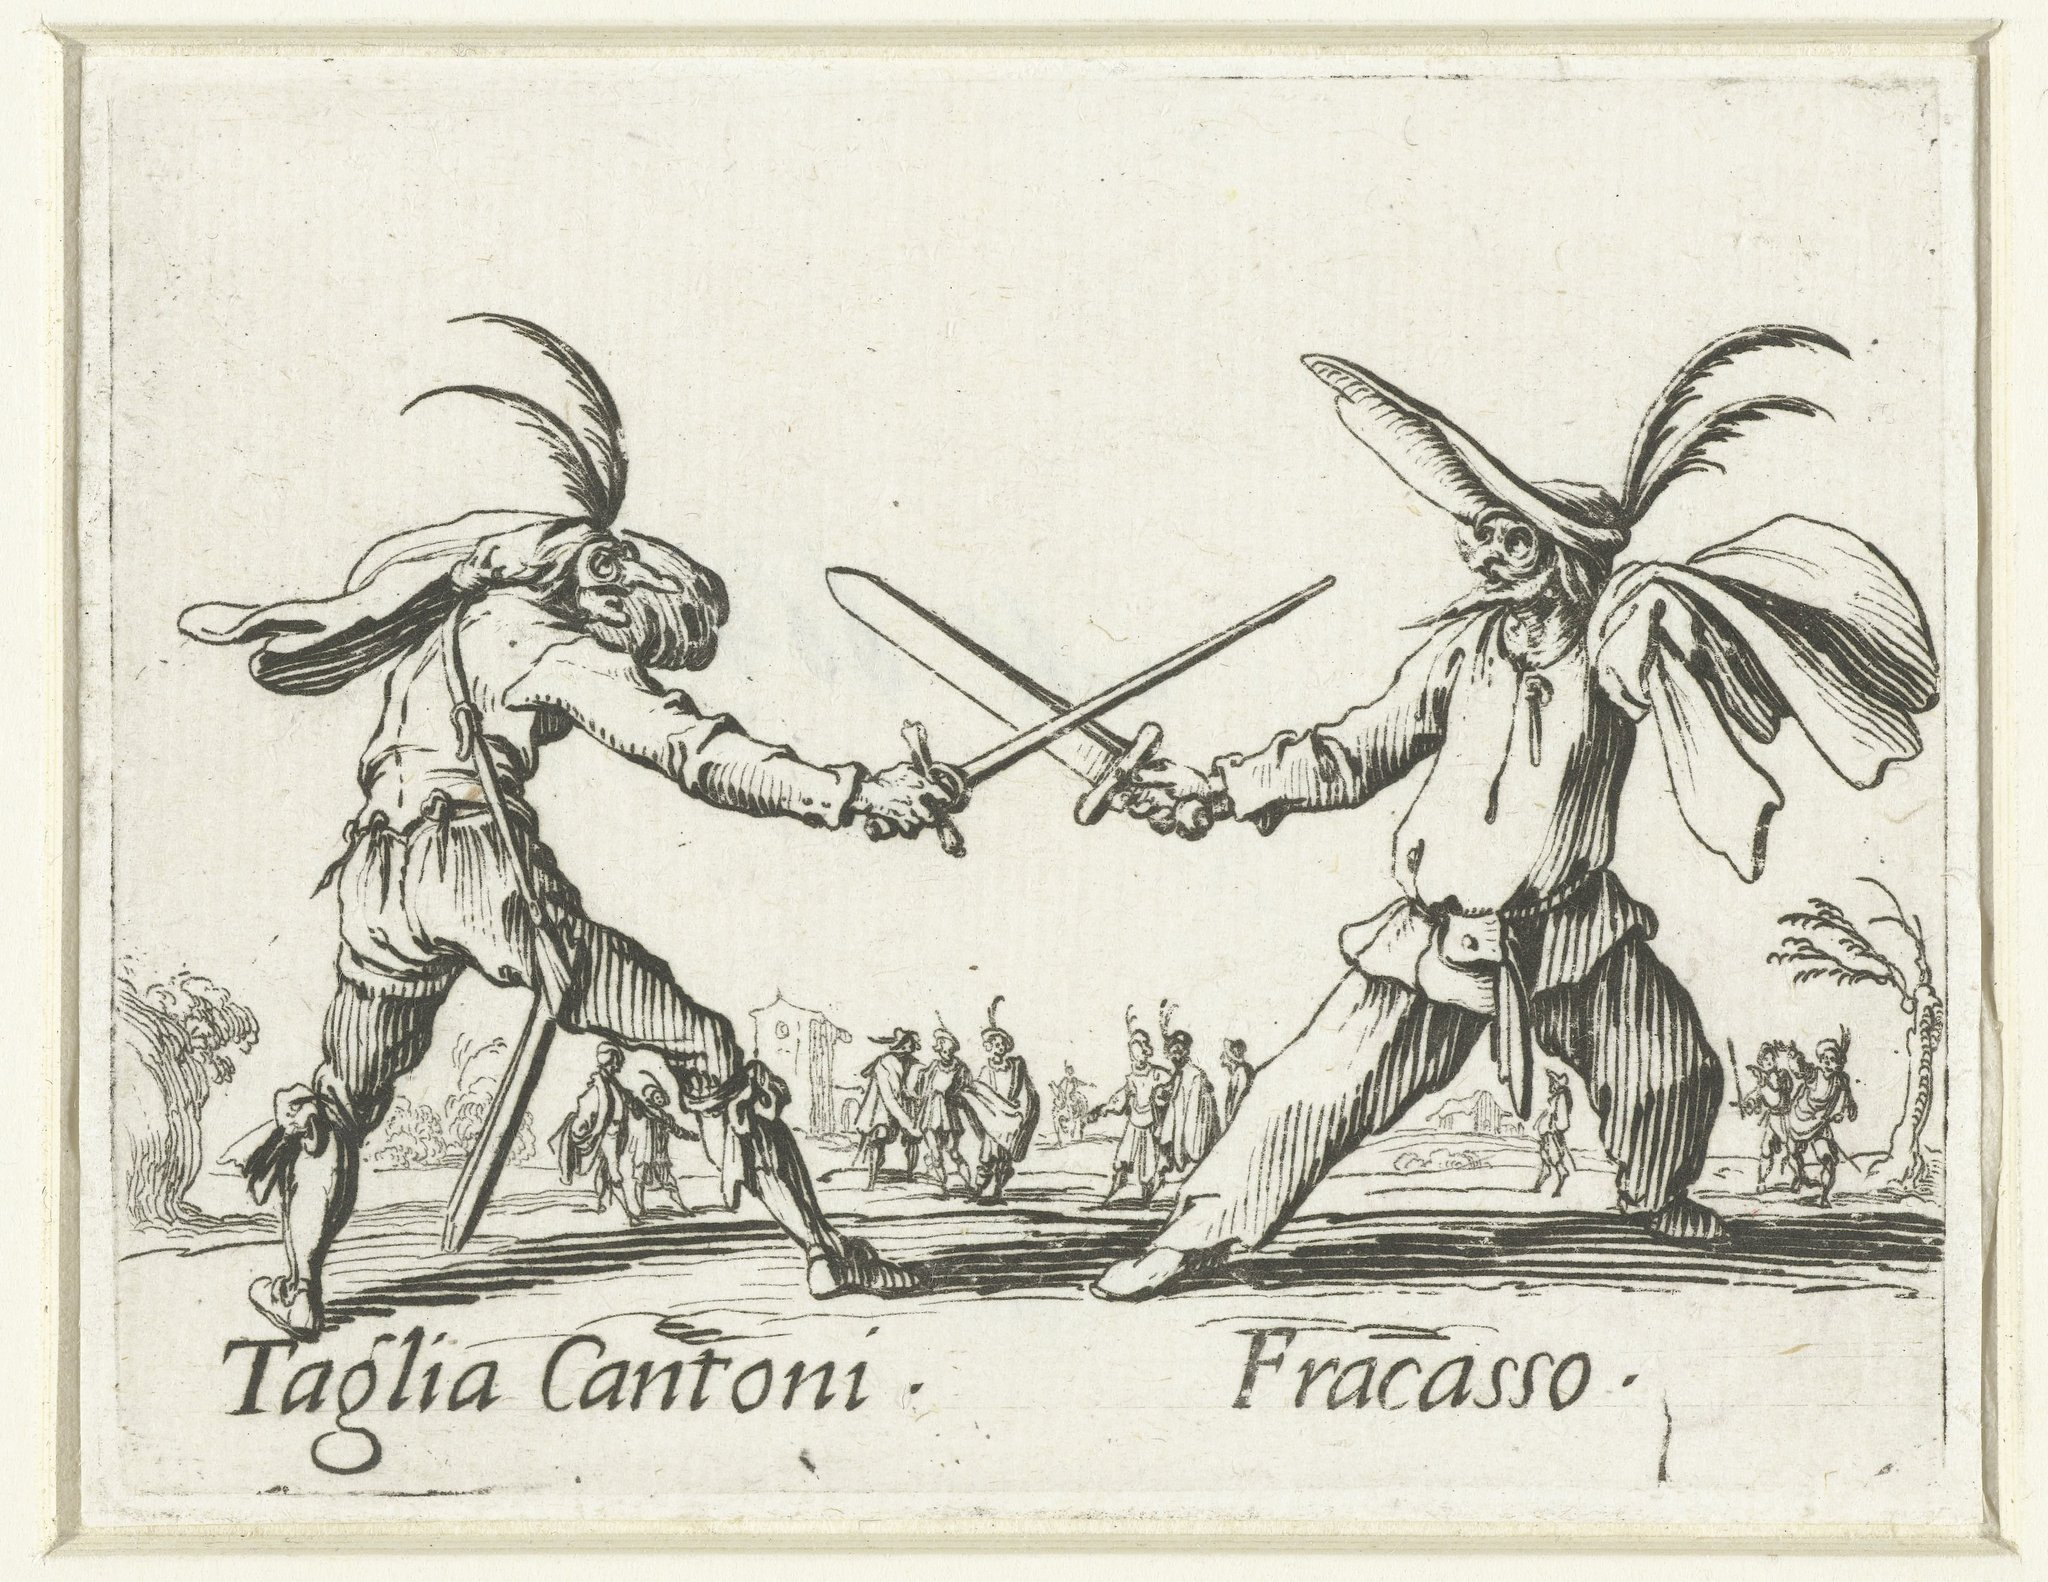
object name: print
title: Twee straatartiesten als Taglia Cantoni en Fracasso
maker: jacques callot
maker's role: draughtsman, print maker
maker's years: 1592-1635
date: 1621-1622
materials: paper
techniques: etching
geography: nancy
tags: types in 'commedia dell'arte', hand-to-hand fighting (~ battle)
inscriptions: collector's mark: Lugt 240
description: Twee artiesten met gevederde hoofddeksels op staan tegenover elkaar en kruisen de zwaarden. Onder de figuren staan hun namen genoteerd. Deze prent is onderdeel van een serie van 23 prenten (24 incl. titelprent) met telkens op de voorgrond twee straatartiesten verkleed als figuren uit de Italiaanse commedia dell'arte, en op de achtergrond toeschouwers die in de buitenlucht een (dans)voorstelling van straatartiesten gadeslaan.